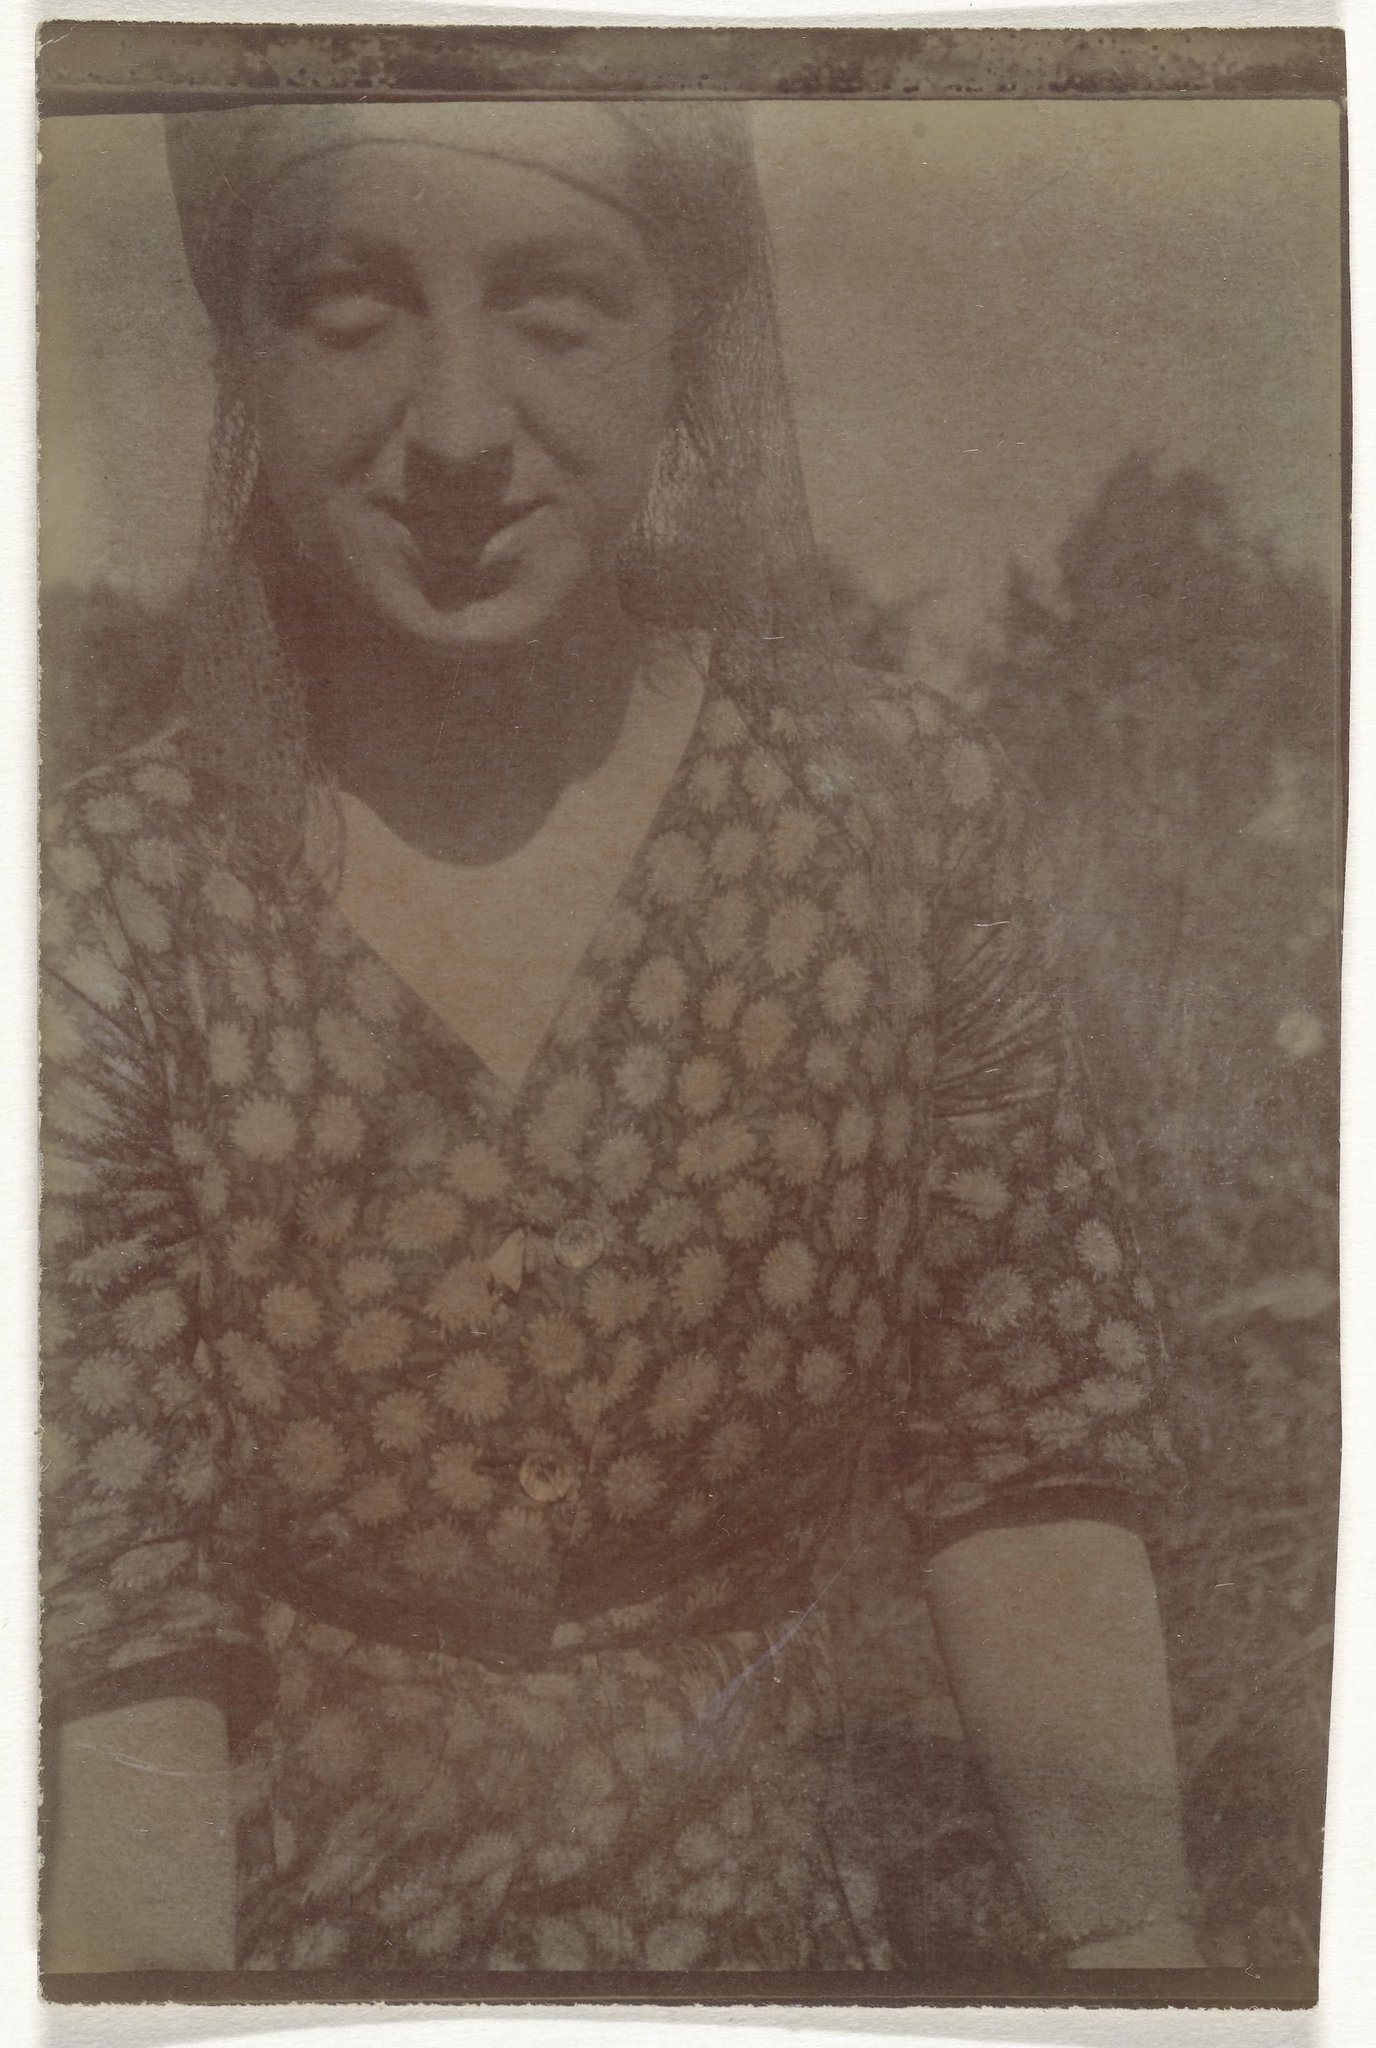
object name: photograph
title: Portret van Irene With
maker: Anonymous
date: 1920-1937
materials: paper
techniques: gelatin silver print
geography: germany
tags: amsterdam, historical persons - bb - woman, germany